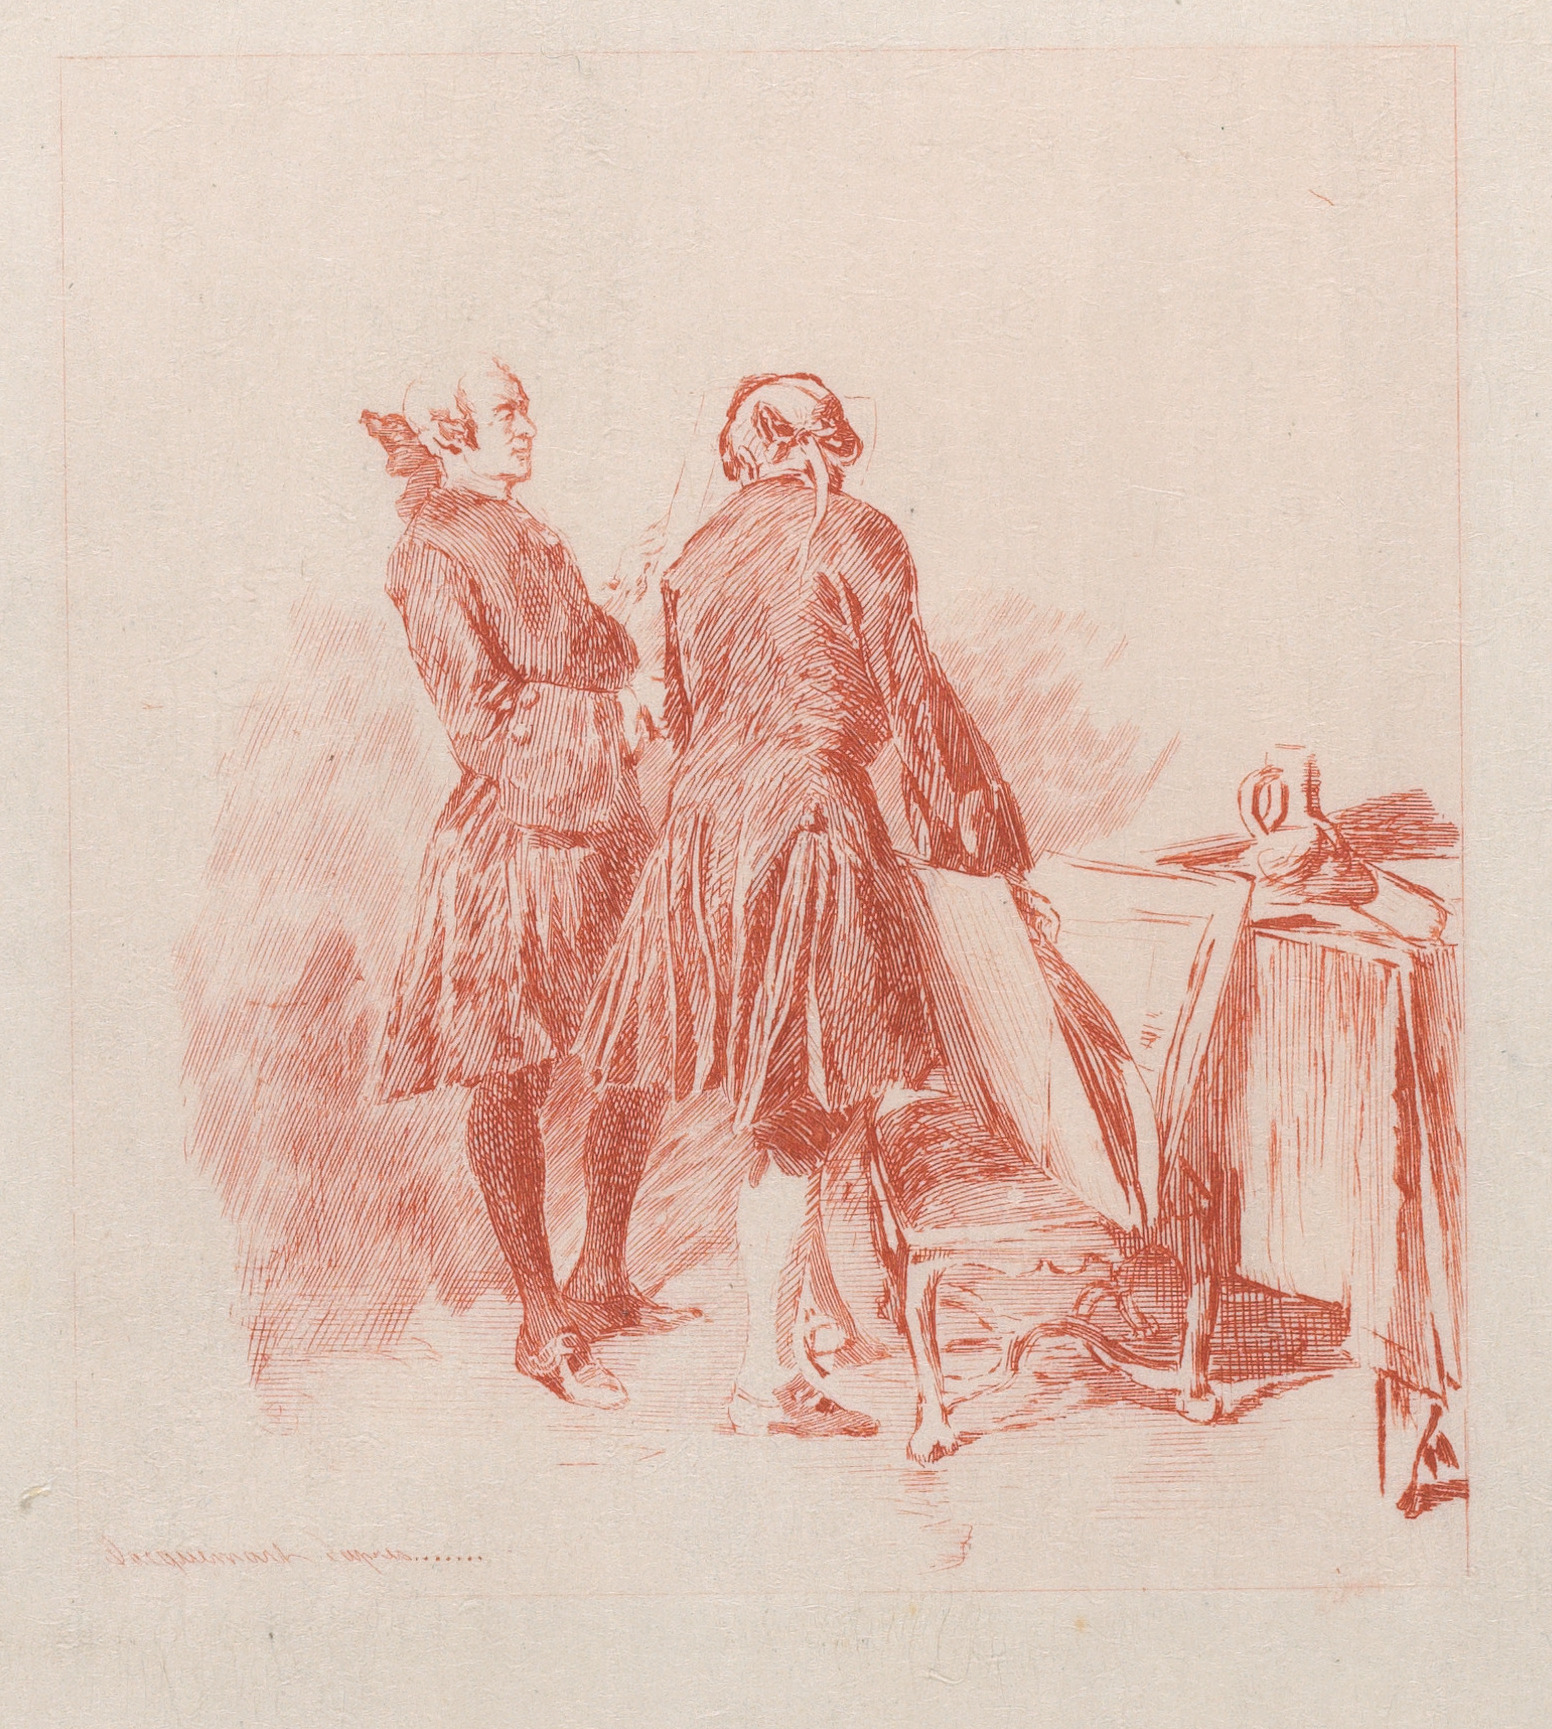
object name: print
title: The Print Enthusiast, after a drawing by Meissonier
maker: jules-ferdinand jacquemart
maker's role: artist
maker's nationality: french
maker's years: 1837-1880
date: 1877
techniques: etching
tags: men